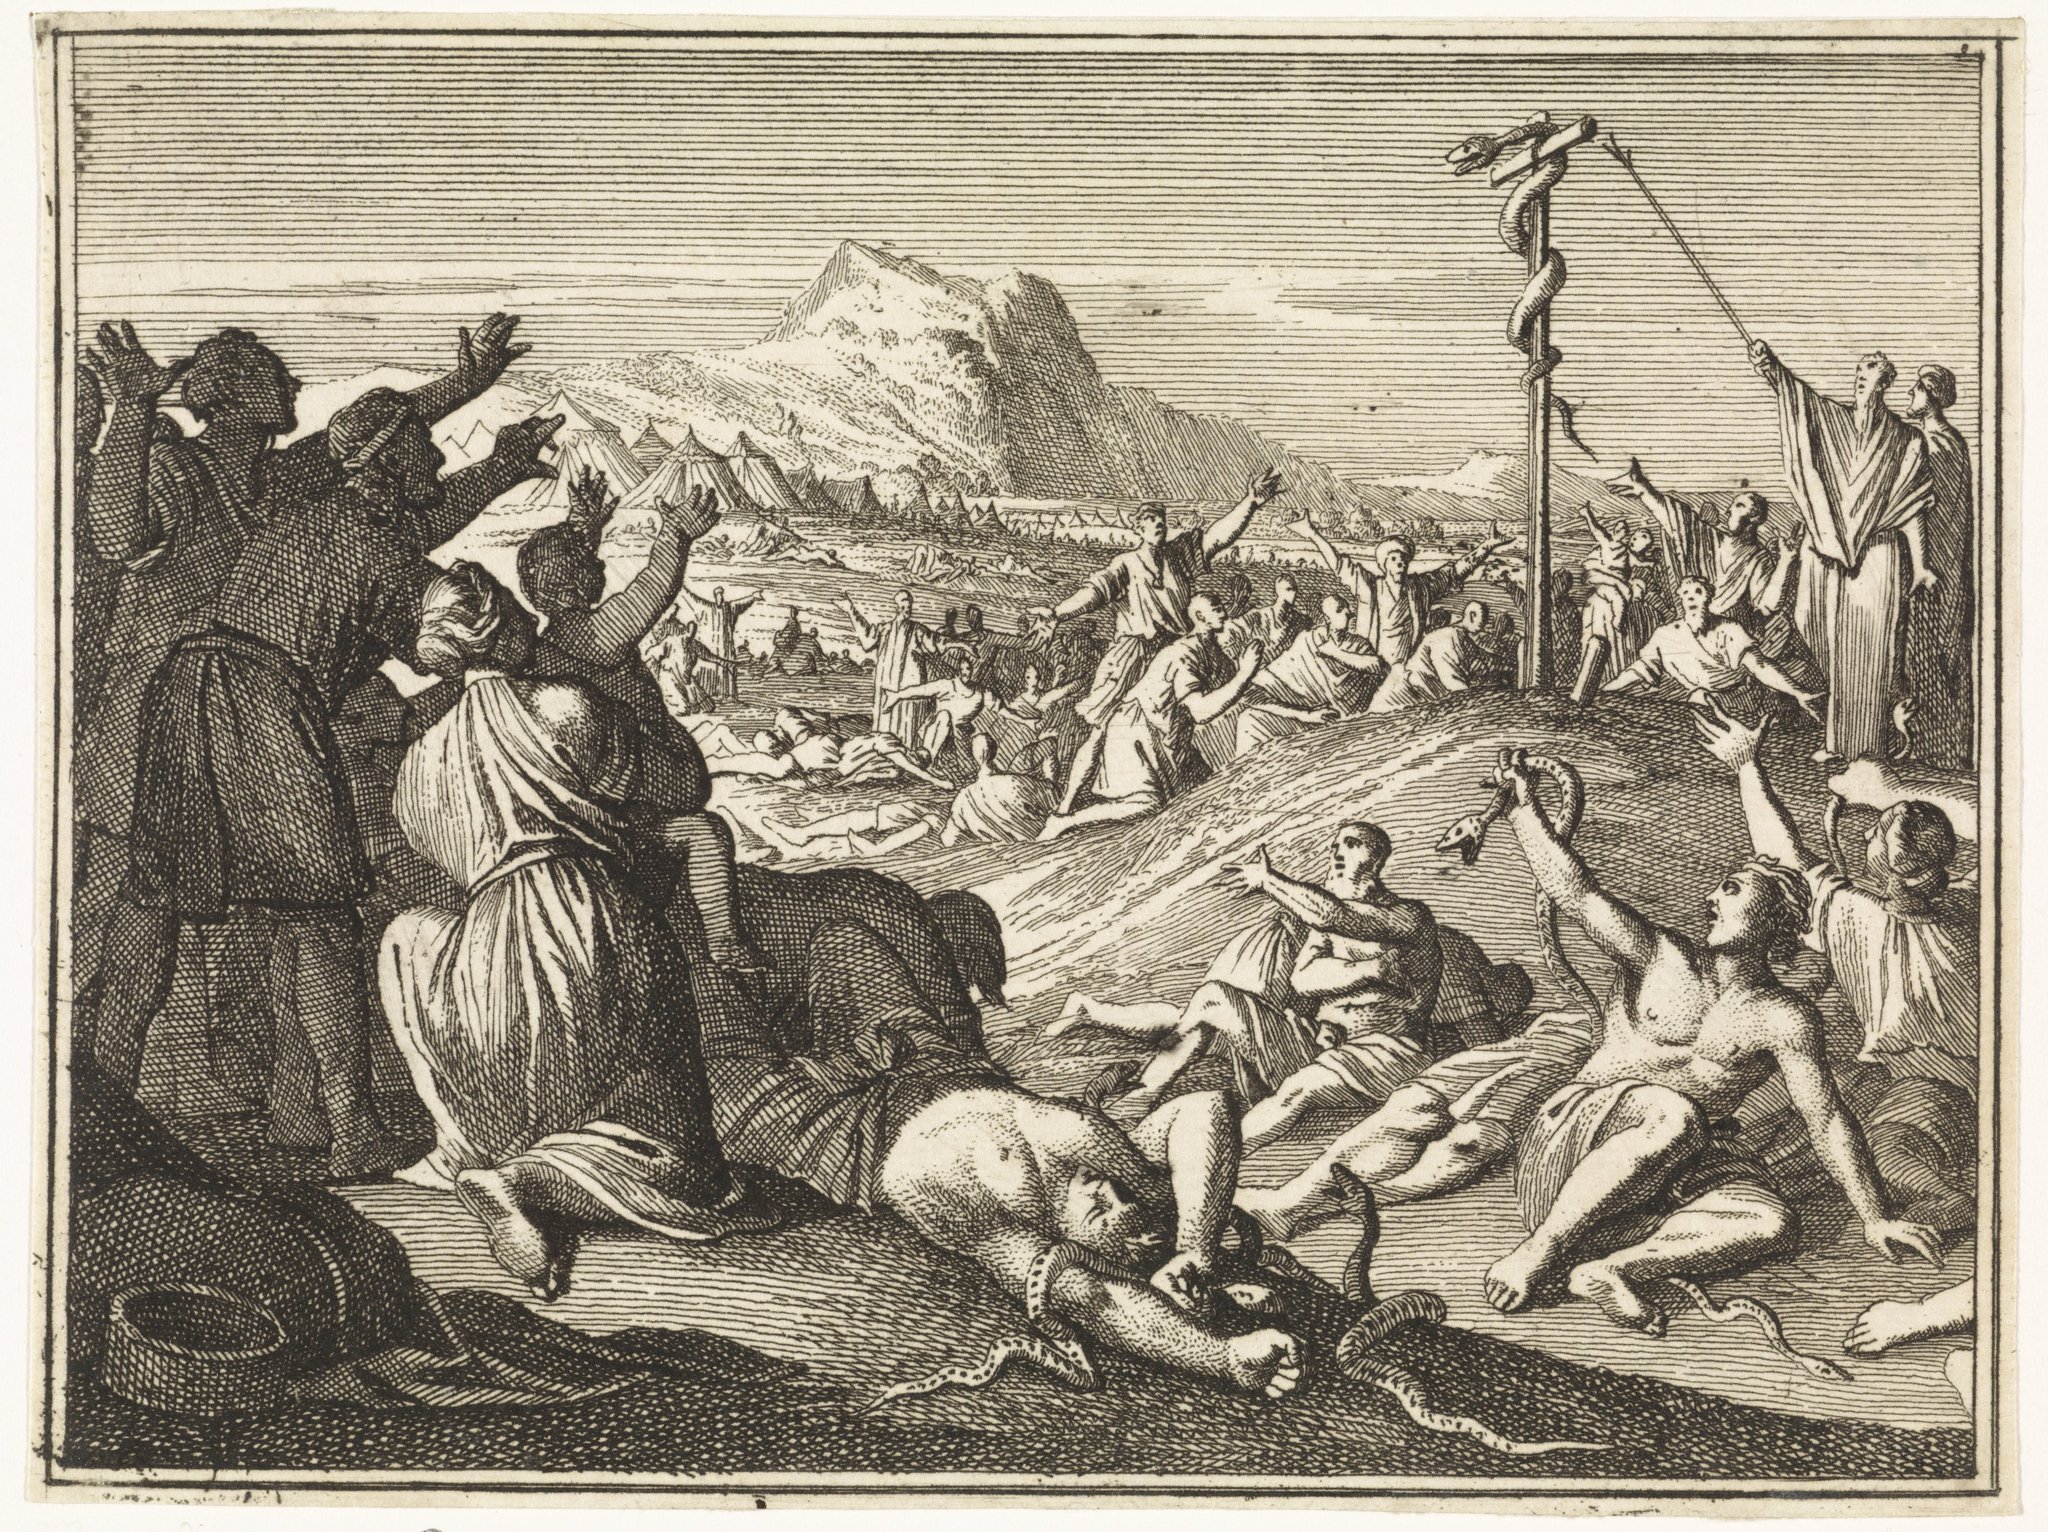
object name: print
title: Mozes en de koperen slang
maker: caspar luyken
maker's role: draughtsman, print maker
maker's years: 1672-1708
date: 1712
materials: paper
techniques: etching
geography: amsterdam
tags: anyone who is bitten by a snake is cured by looking at the brazen serpent; the serpent (or dragon) is usually depicted on a tau-shaped cross or on a pillar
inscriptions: number: ‘73’, collector's mark: Lugt 2228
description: Illustratie uit: Luyken, Jan. De schriftuurlyke geschiedenissen en gelykenissen van het Oude en Nieuwe Verbond, 2 delen. Amsterdam: Wed. Pieter Arentsz II en Cornelis van der Sys, 1712, dl. I.